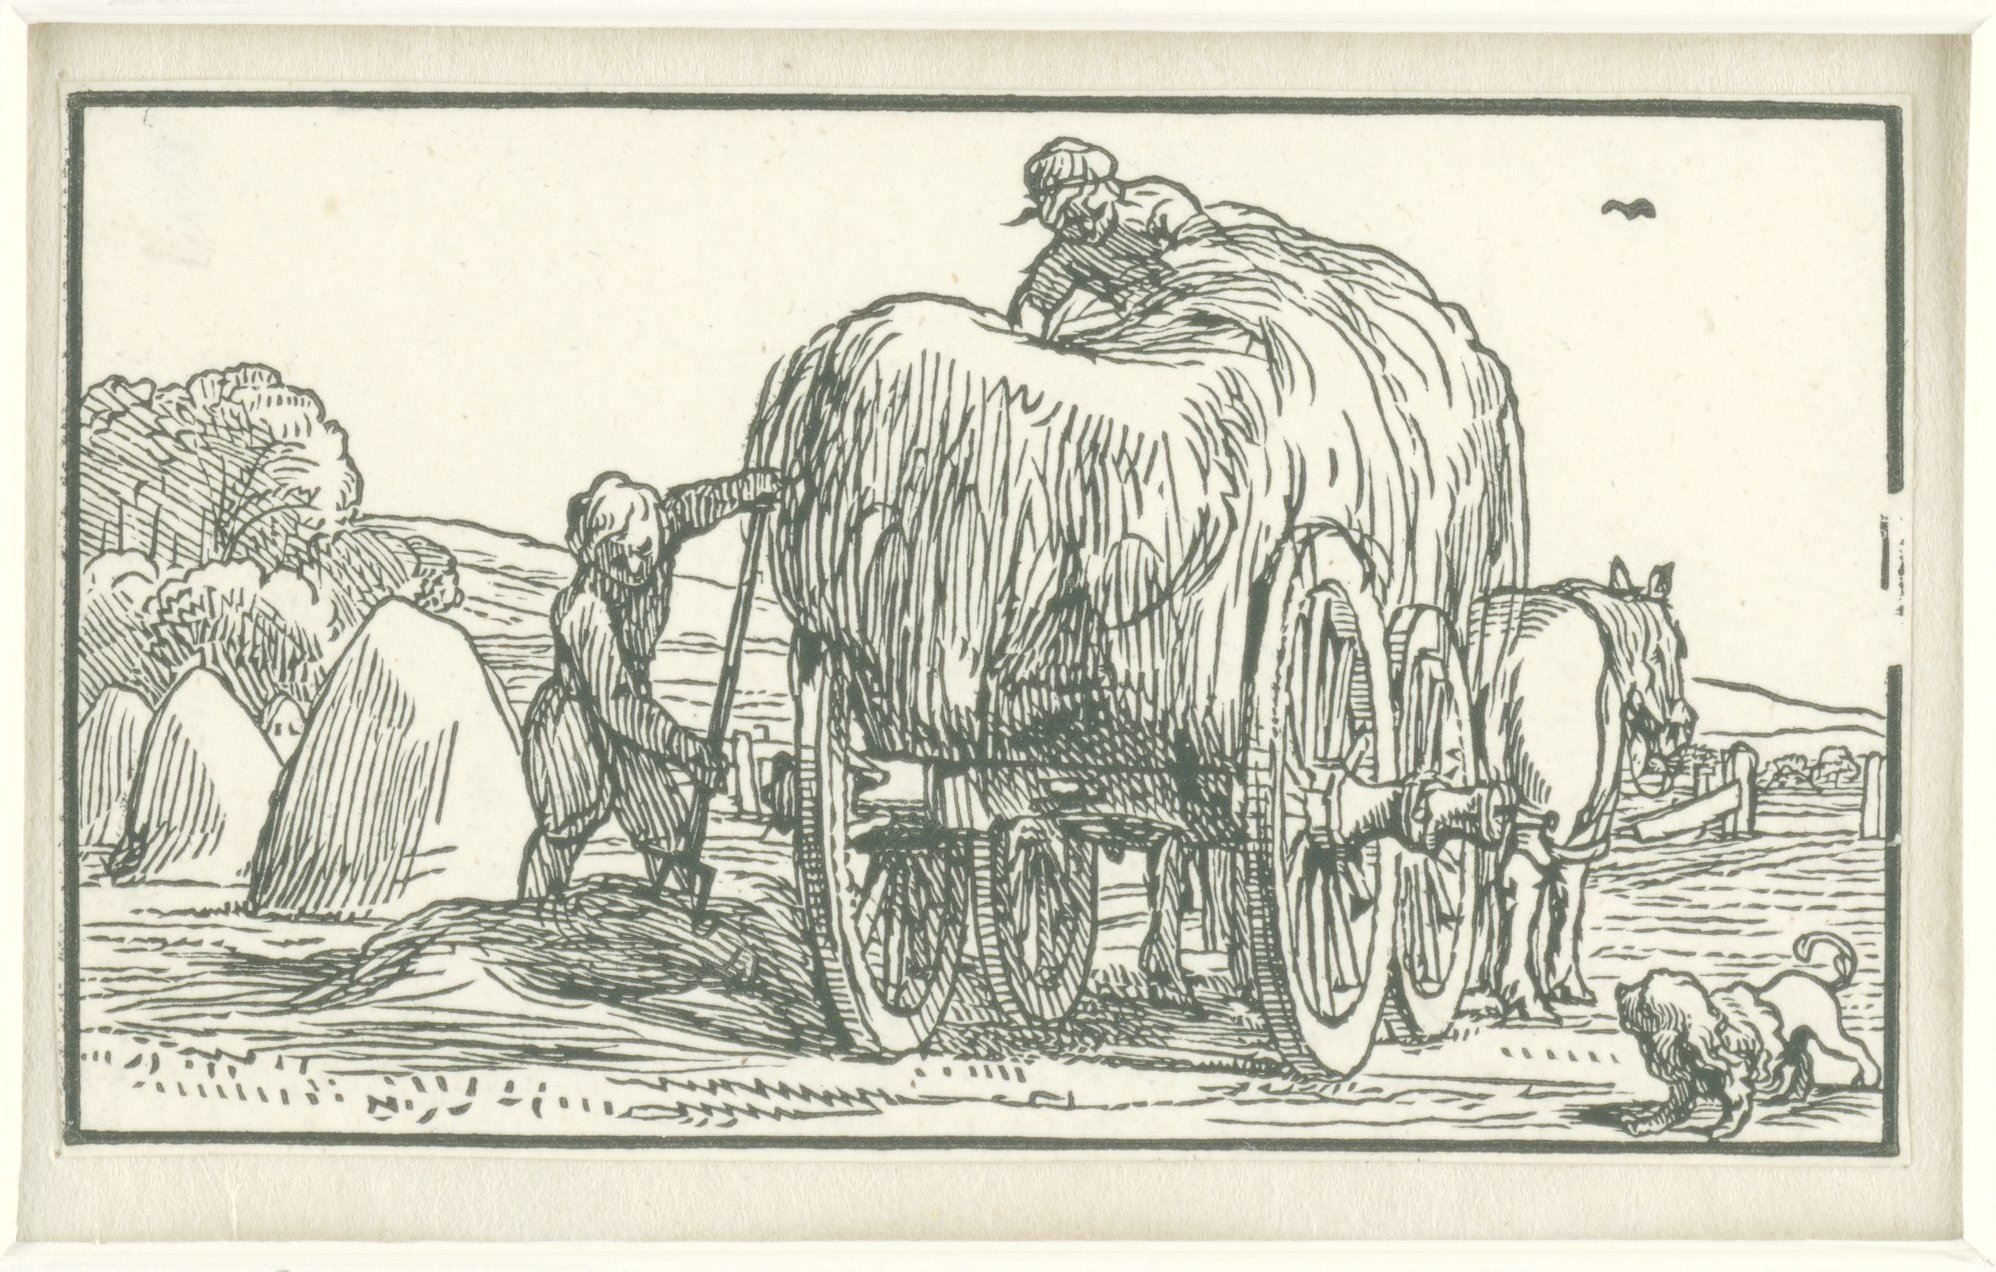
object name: print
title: Juli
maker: dirck de bray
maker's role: draughtsman, painter, print maker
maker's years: 1625-1694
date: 1635-1694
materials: paper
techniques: woodcut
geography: netherlands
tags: july and its 'labours' (+ with leo (july))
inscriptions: collector's mark: Lugt 240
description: Een hooiwagen wordt door twee mannen volgeladen met hooi. Op de voorgrond blaft een hond (leeuw?).